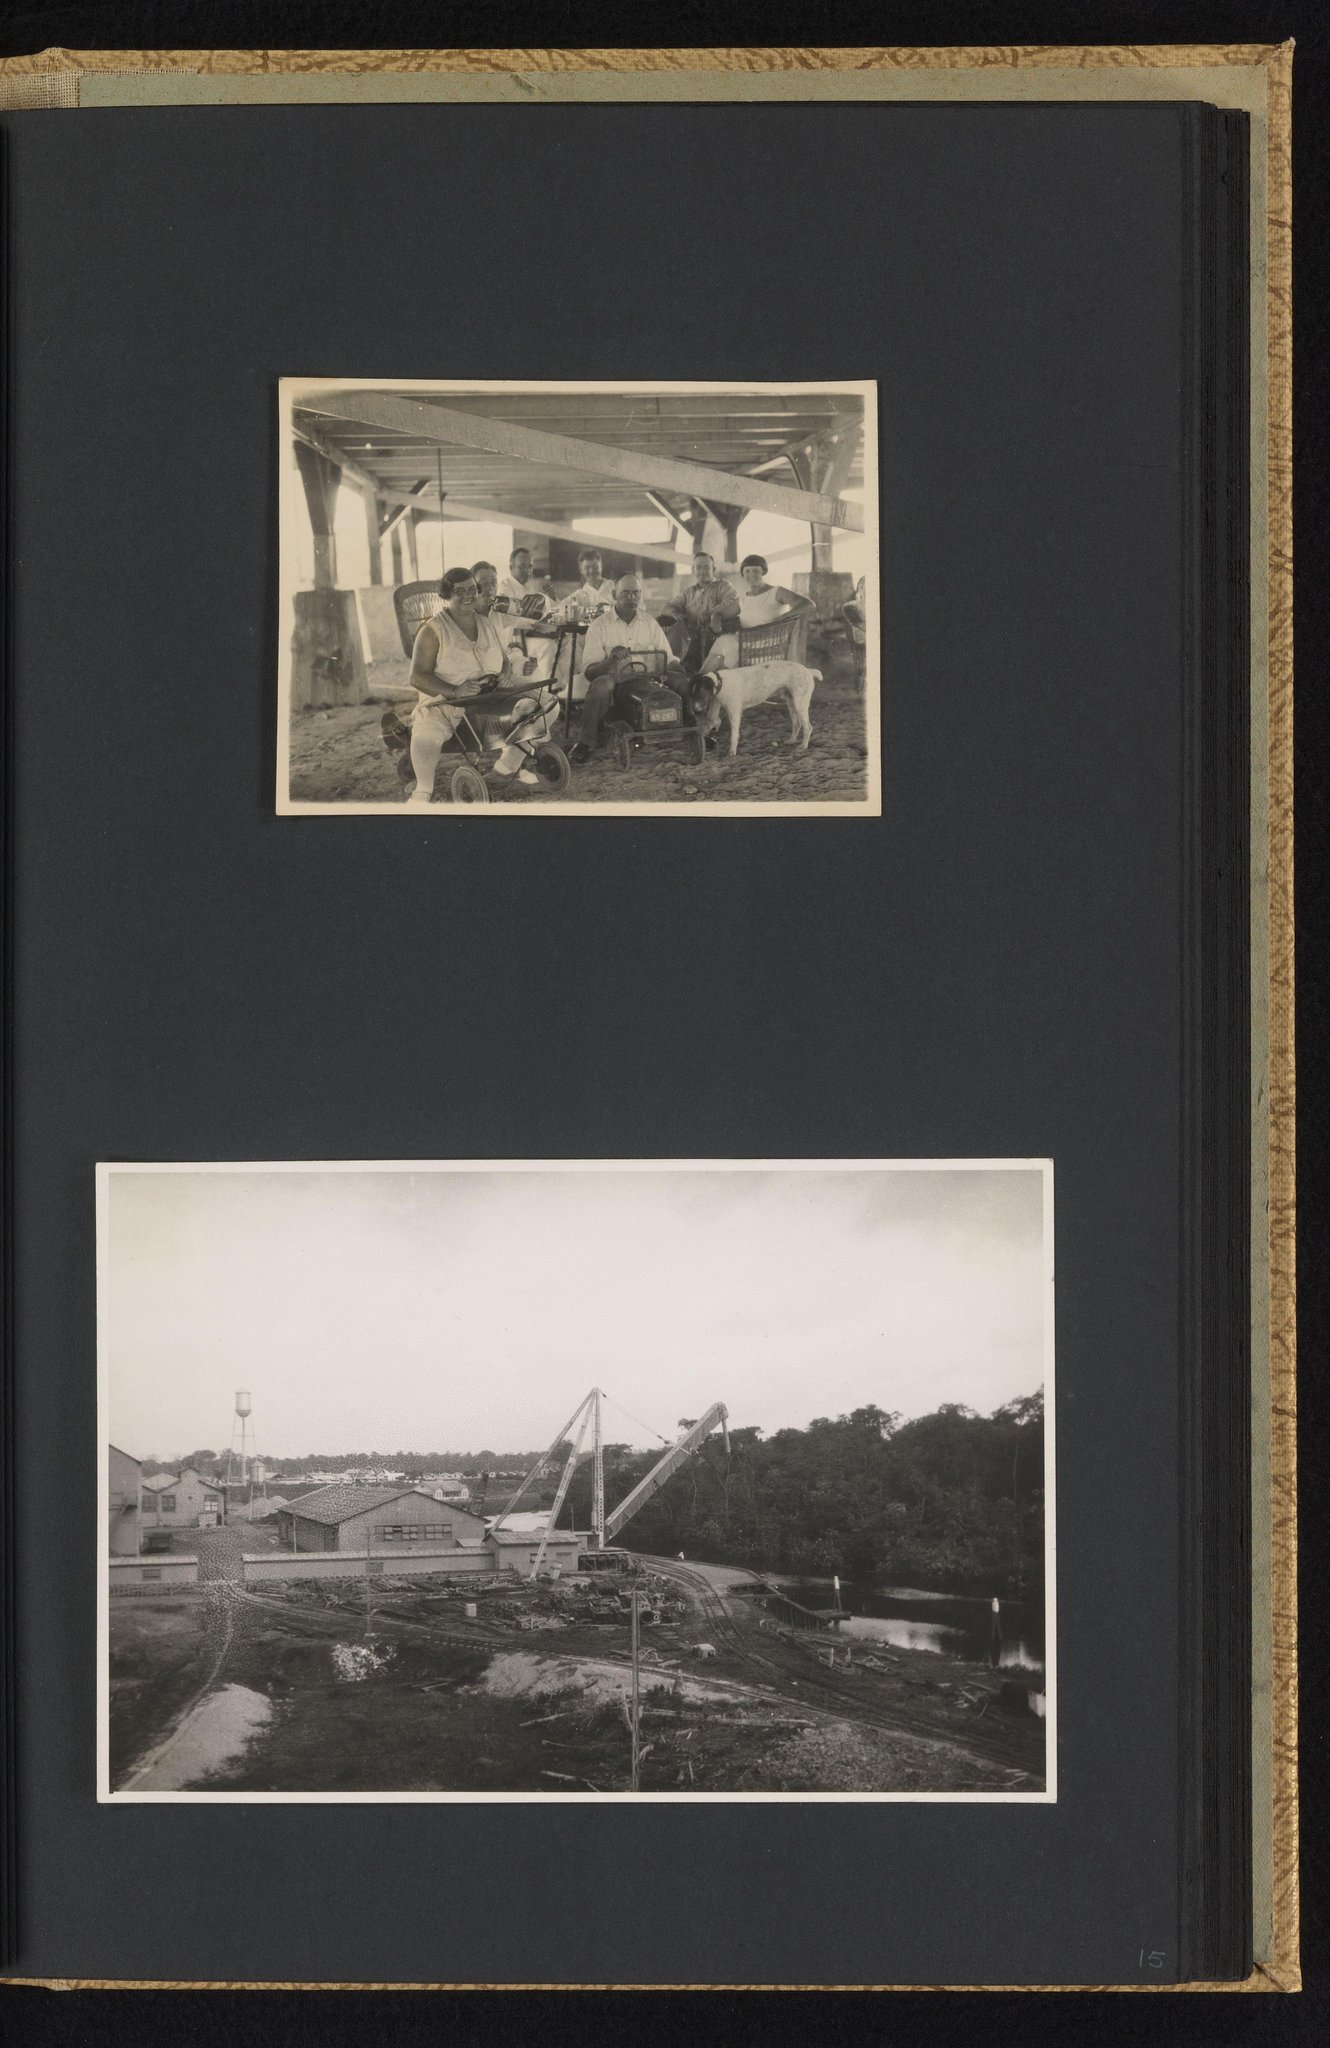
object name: photograph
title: Groepsportret en fabrieksterrein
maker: Anonymous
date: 1929-1930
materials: paper, photographic support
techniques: gelatin silver print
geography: suriname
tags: exterior of industrial structures, factories, dock crane, anonymous historical persons portrayed in a group, in a group-portrait, suriname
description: Albumblad met twee foto's: groep in een schuur met speelgoed en gezicht op fabrieksterrein met laadkraan. Onderdeel van het album van de familie Guilonard over de bauxietwinning in Moengo en Albina in Suriname in de jaren 1929-1930.